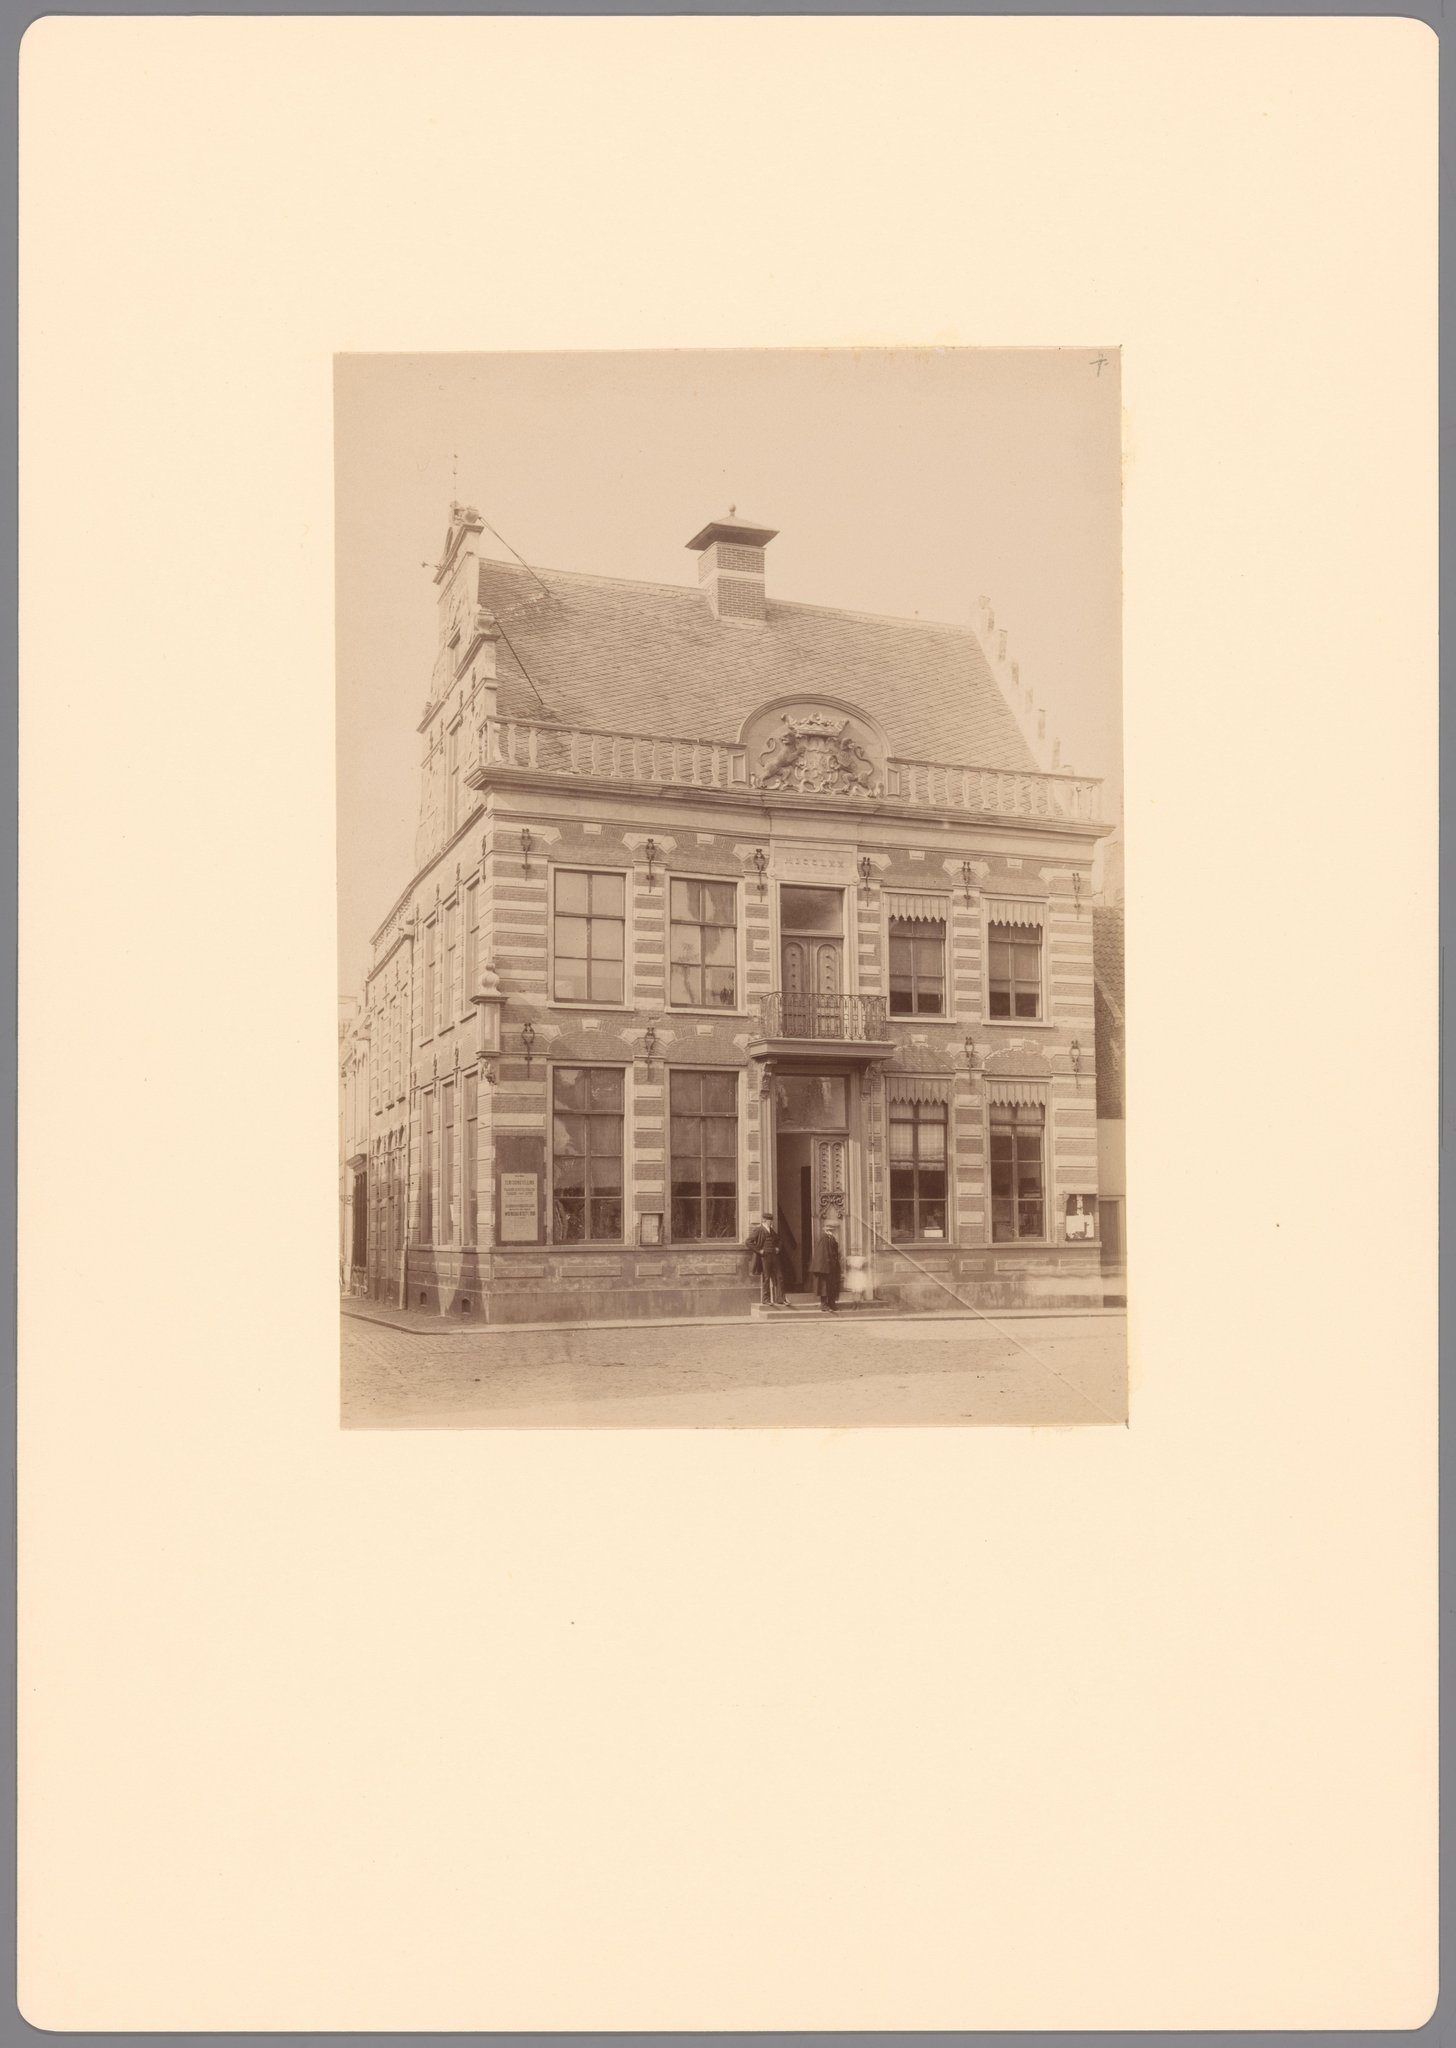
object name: photograph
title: Gezicht op het stadhuis van Hattem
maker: anoniem (monumentenzorg)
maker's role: fotograaf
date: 1890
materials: cardboard, photographic support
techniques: albumen print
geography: hattem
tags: townhall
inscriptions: annotation: ‘t’, annotation: ‘Het Raadhuis te Hattem’